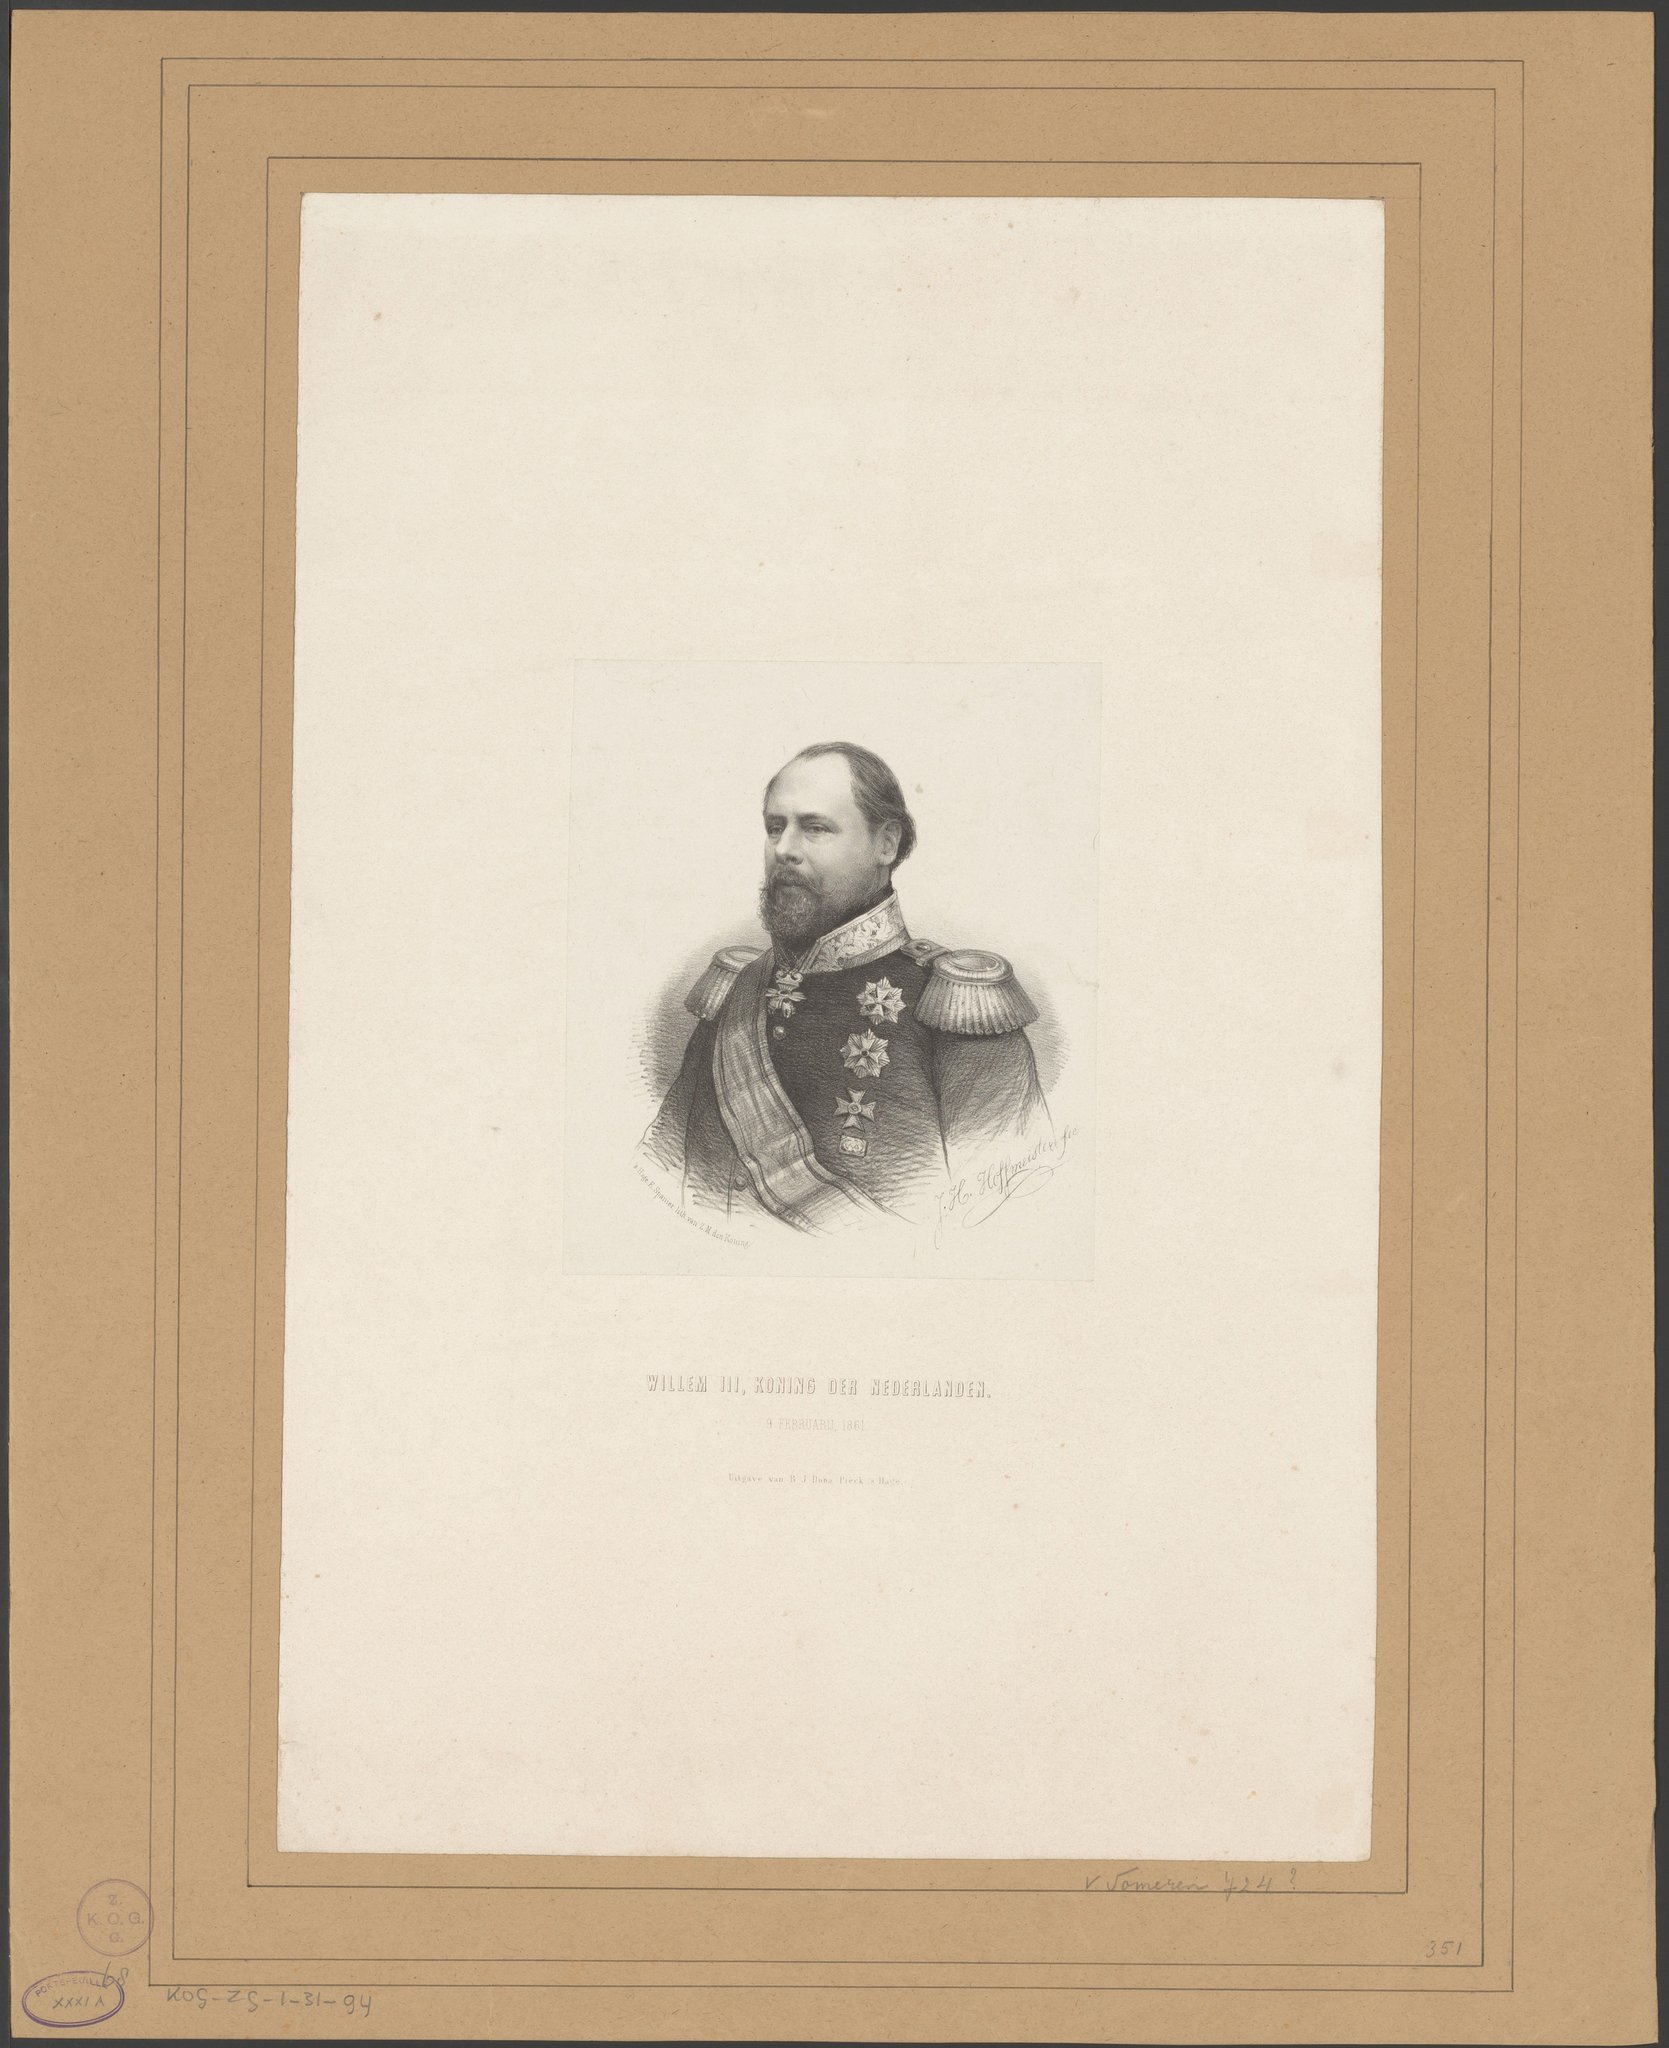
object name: print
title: Portret van Willem III, koning der Nederlanden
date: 1861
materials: paper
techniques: lithograph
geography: the hague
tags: brussels, willem iii (koning der nederlanden), historical persons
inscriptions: collector's mark: Lugt 1641, stamp, collector's mark: Lugt 1641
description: Onderwerpsrubrieken binnen de Atlas Zeden en Gewoonten: Portretten, Portretten van Vorsten uit het huis van Oranje, Regeerende Vorsten, Koningen uit het huis van Oranje.